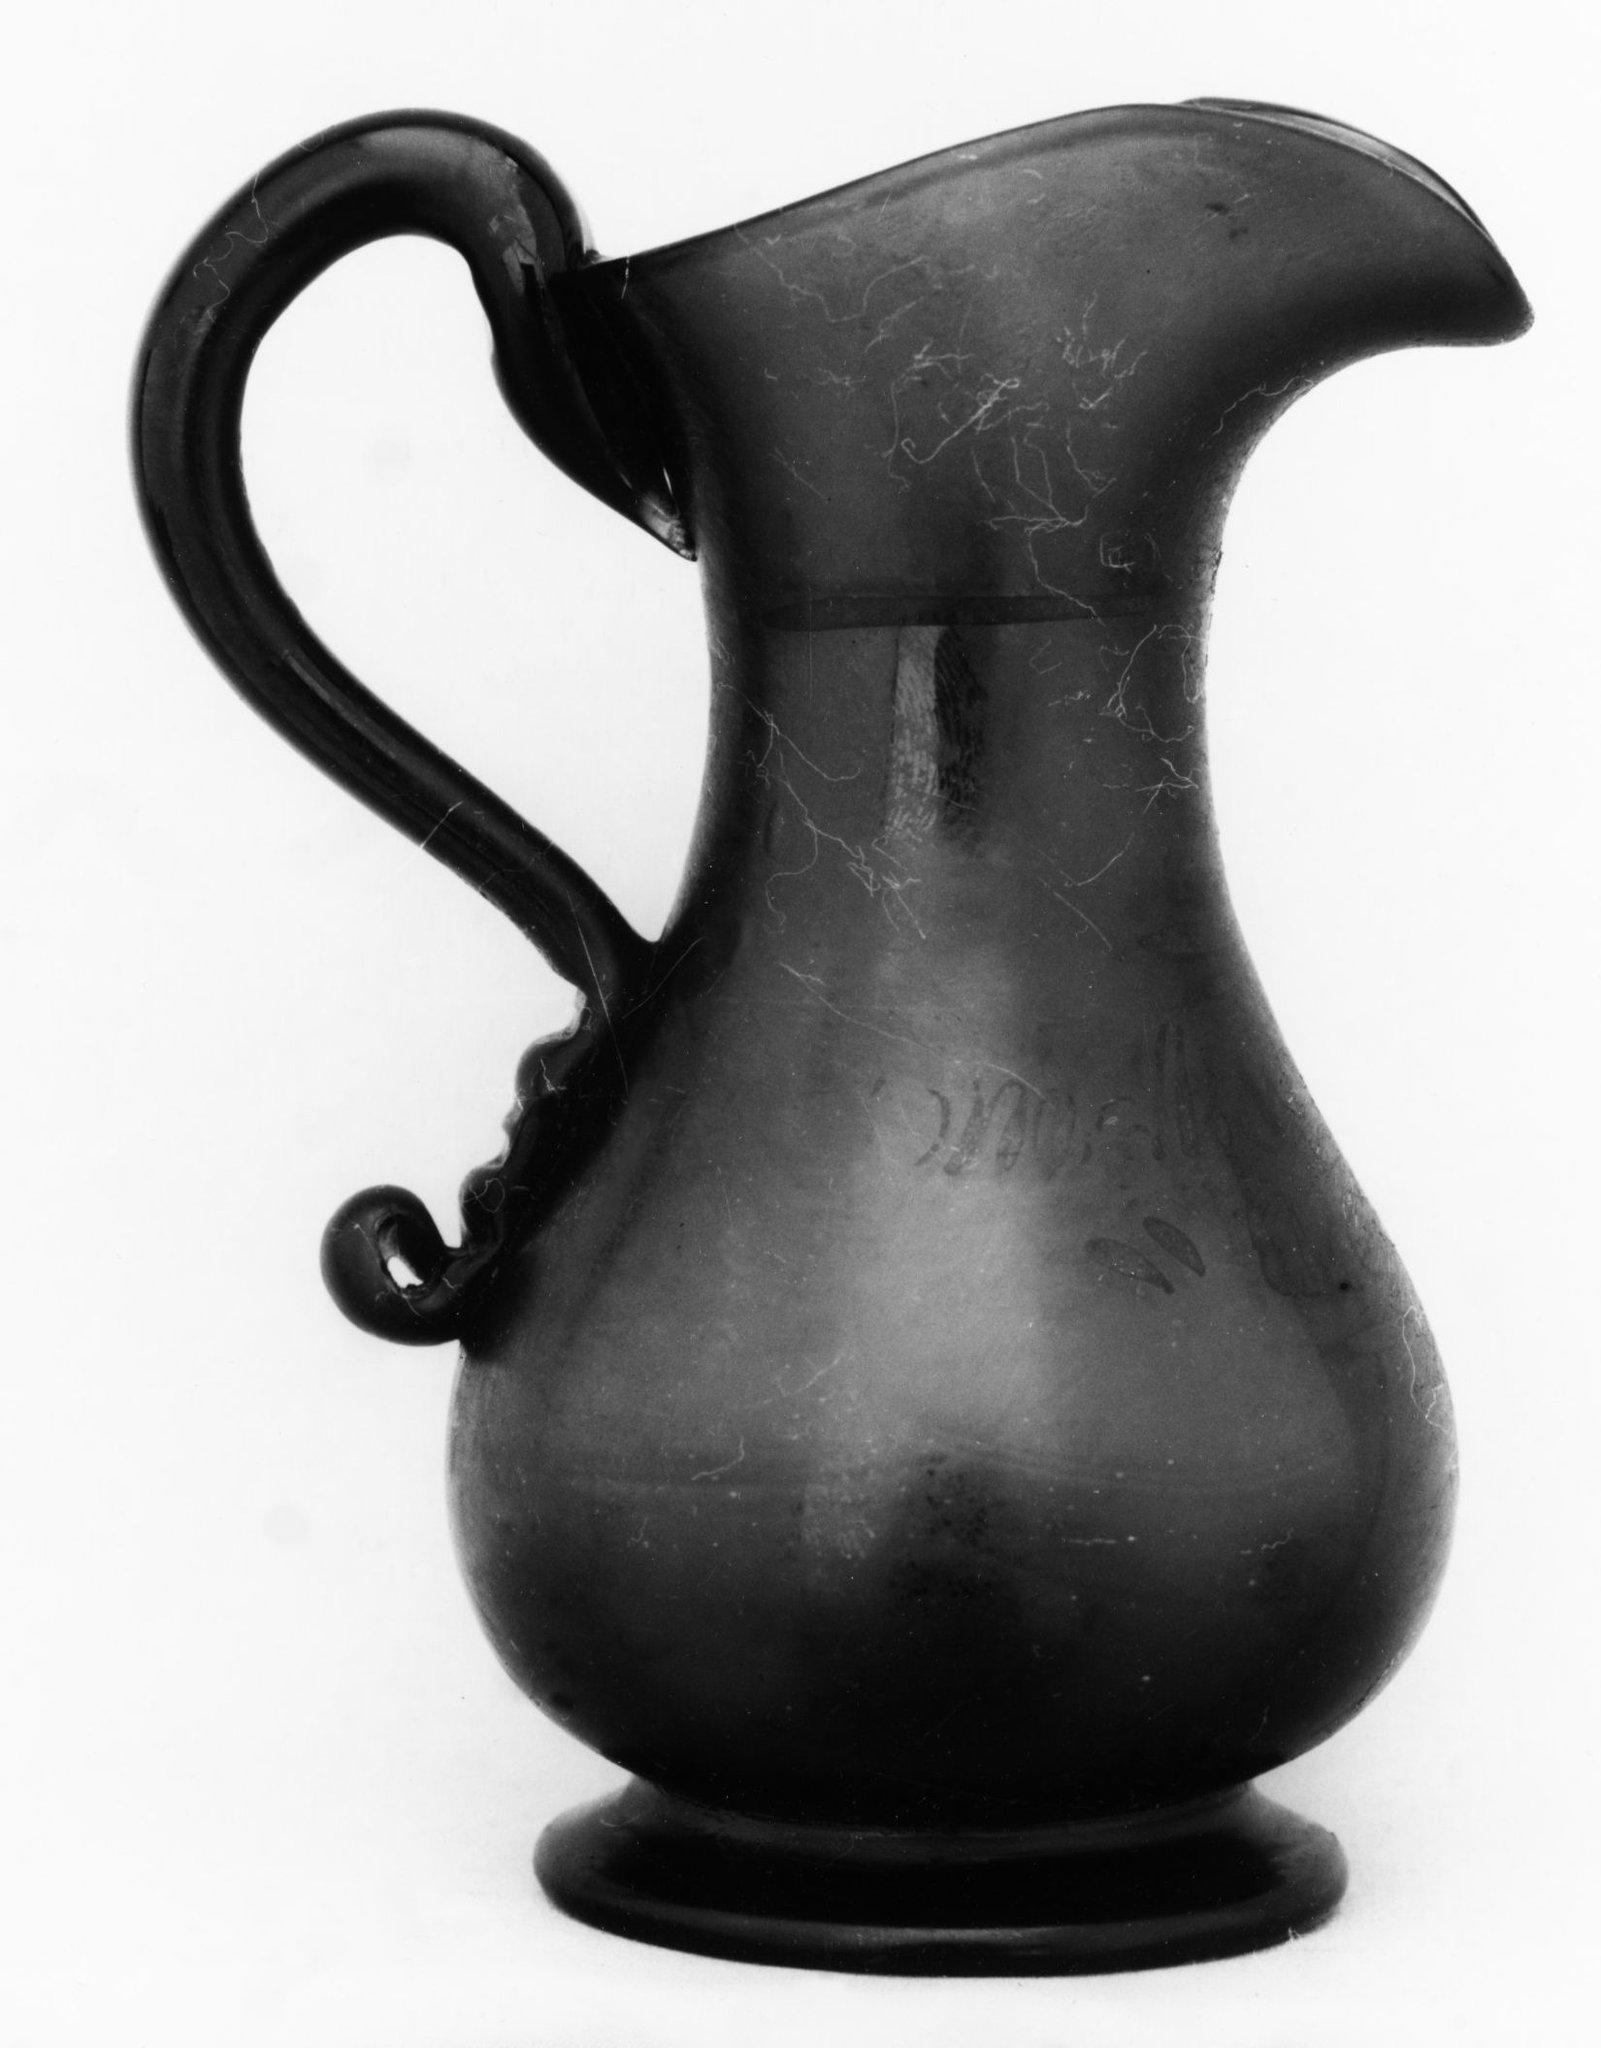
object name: cream pot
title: Creamer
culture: british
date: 1801-1900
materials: glass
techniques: glassblowing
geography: england